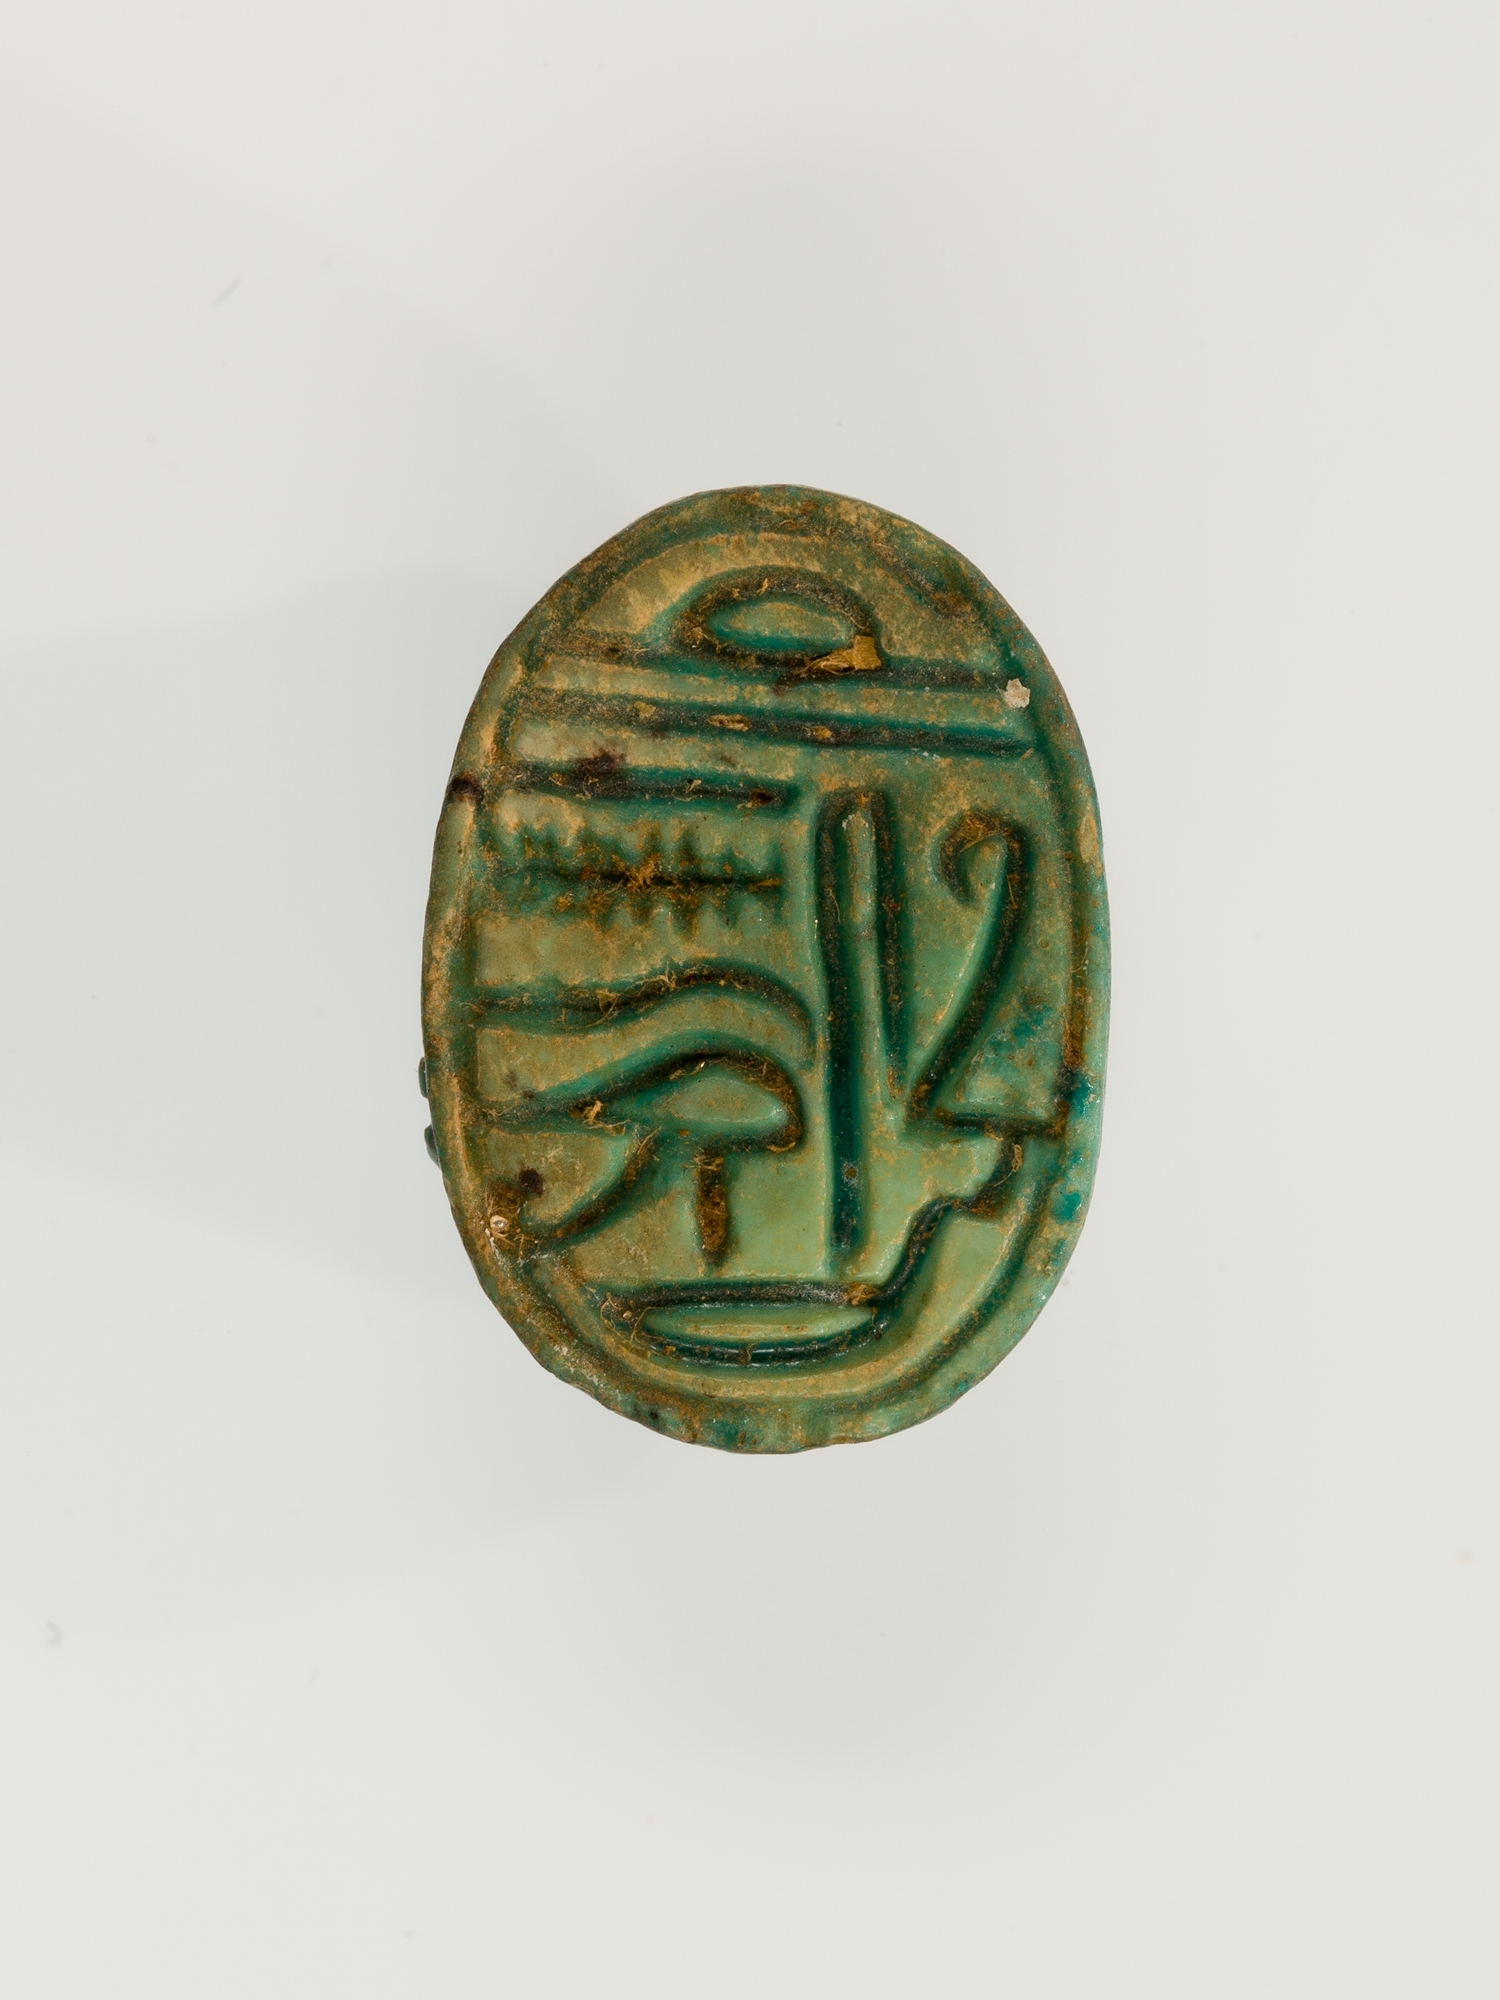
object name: scarab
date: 1295-1070 BCE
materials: stone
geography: egypt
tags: hieroglyphs,scarabs